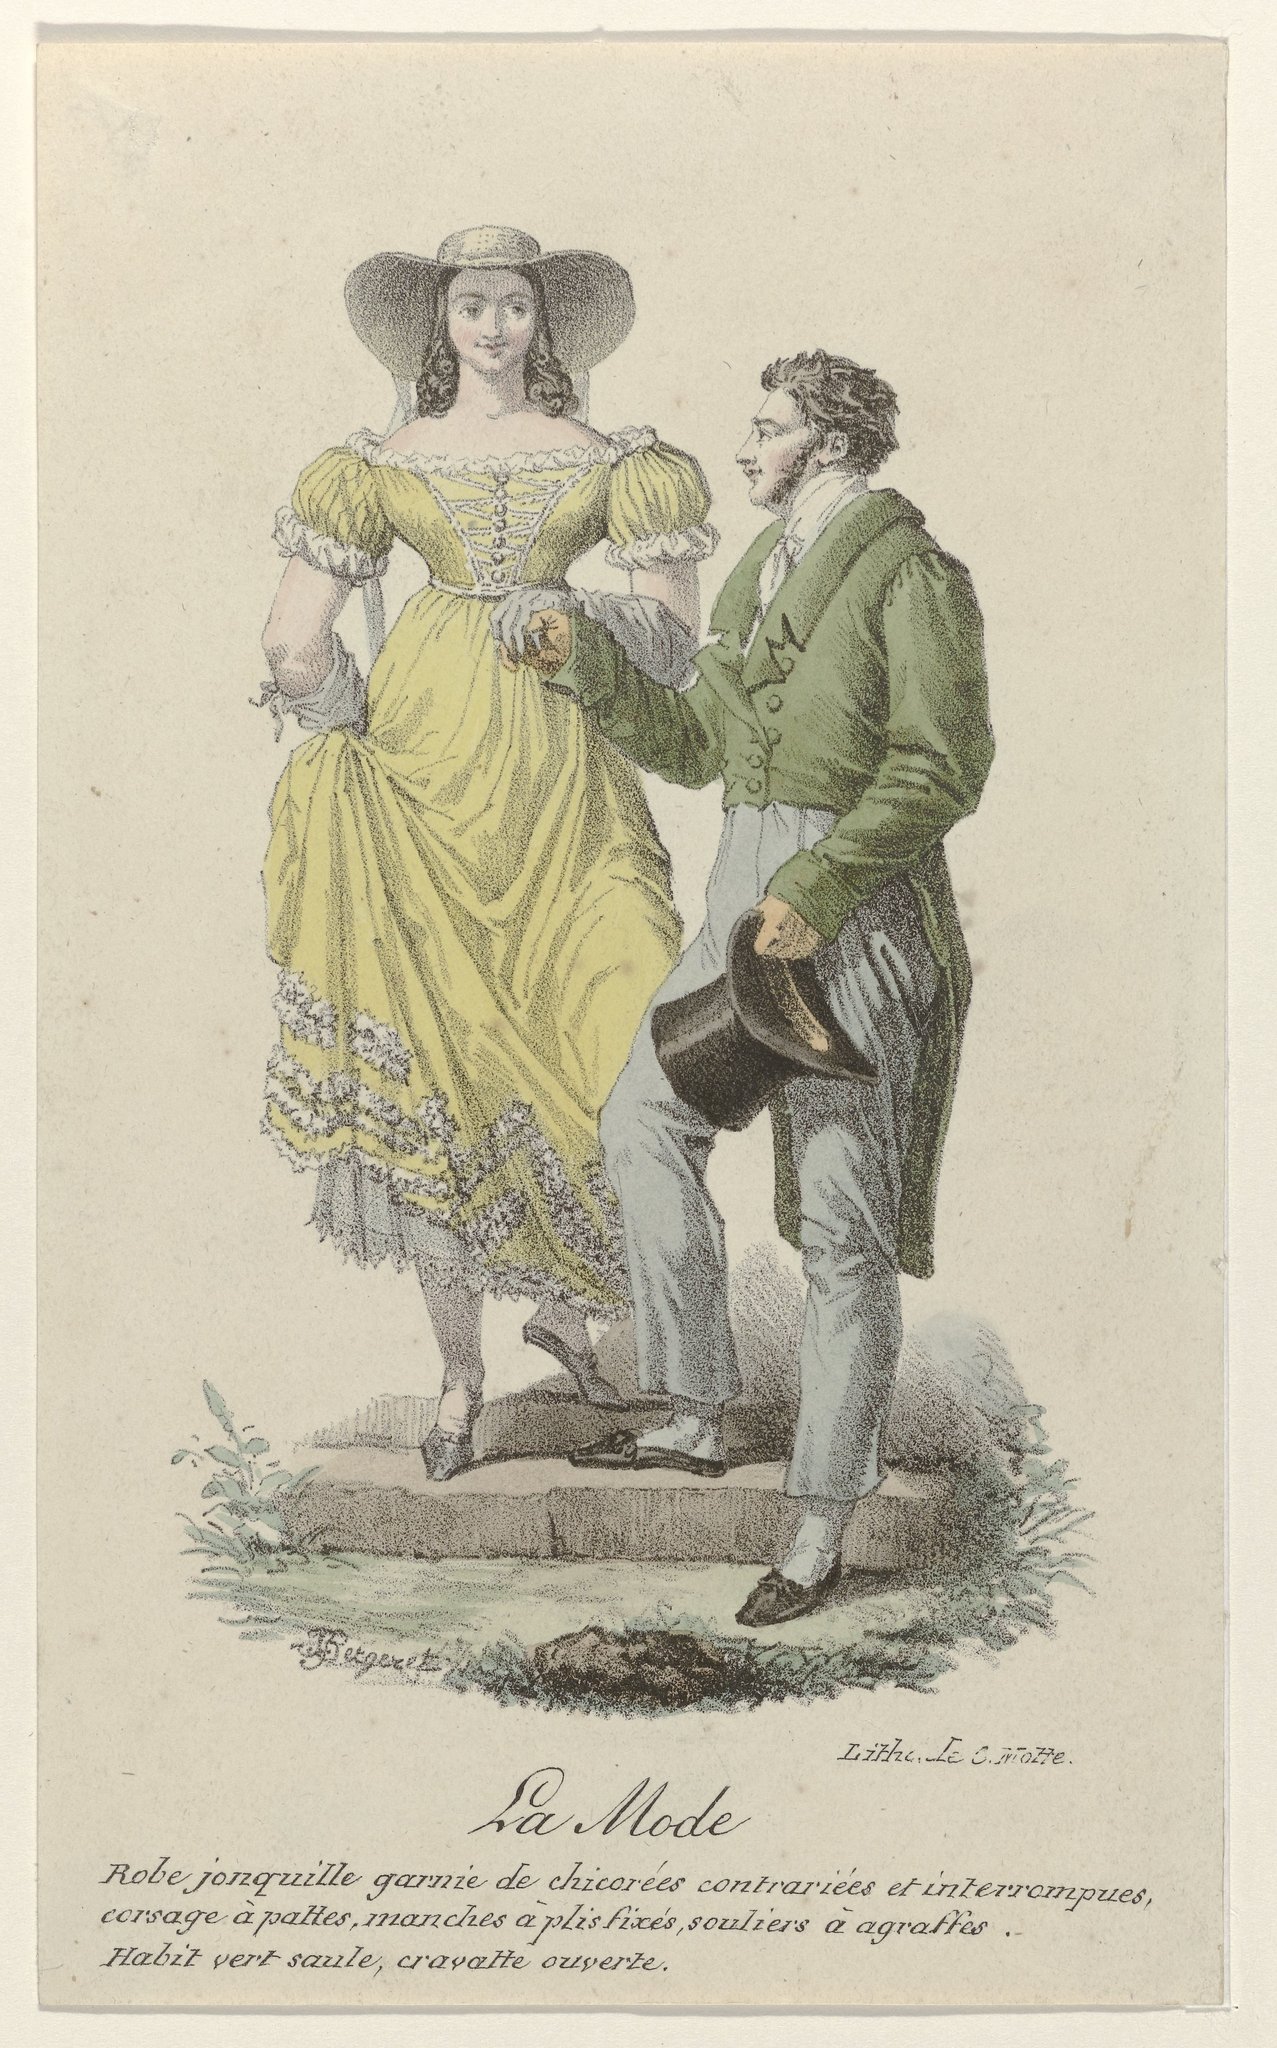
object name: fashion print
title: La Mode, 1821 : Robe jonquill (...)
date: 1821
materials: paper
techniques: hand coloring, lithograph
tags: brooch, agraffe, clasp (+ women's clothes), neck-gear ~ clothing (cravat) (+ men's clothes), trousers, breeches, etc. (pantalon) (+ men's clothes), coat (+ men's clothes), fashion plates, head-gear: hat (+ women's clothes), shoes, sandals (+ women's clothes), gloves, mittens, etc. (+ women's clothes), dress, gown (+ women's clothes), shoes, sandals (+ men's clothes), gloves, mittens, etc. (+ men's clothes)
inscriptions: caption: ‘Robe jonquille garnie de chicorées et interrompues, corsage à pattes, manches à plis fixés, souliers à agraffes. Habit vert-saule, cravatte ouverte.’, title: ‘La Mode’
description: Vrouw in lichtgele japon versierd met 'chicorées et interrompues'. Lijfje of 'corsage à pattes' met korte pofmouwen met plooitjes. Platte schoenen met gespen. Man in groene 'habit' op lange broek. 'Cravatte ouverte'.